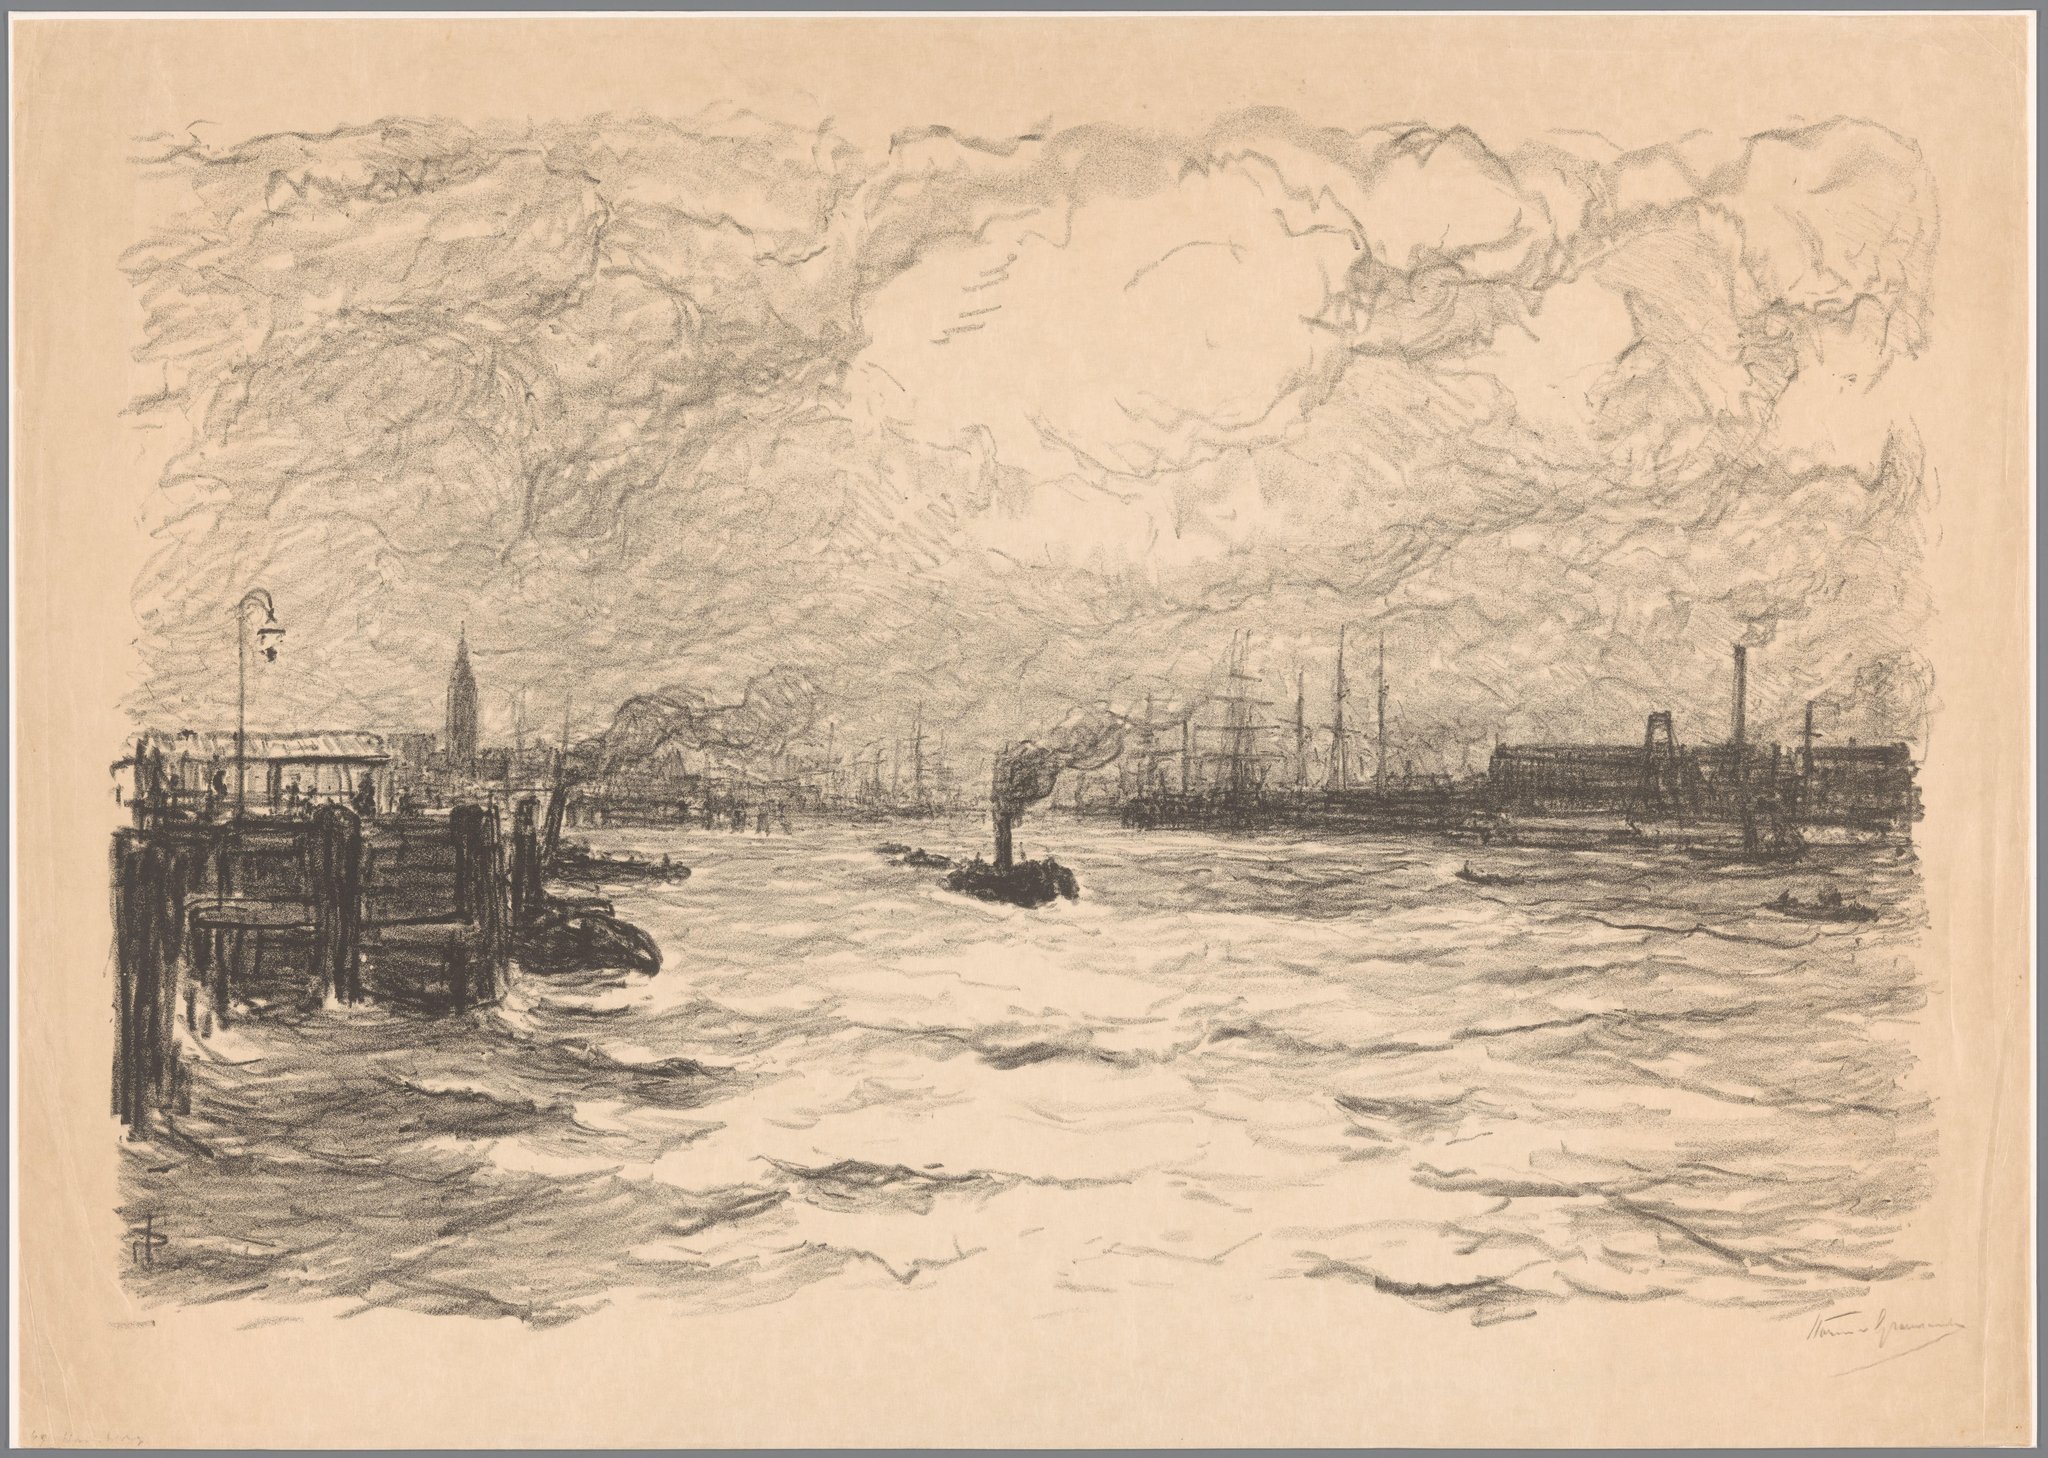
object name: print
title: Havengezicht in Hamburg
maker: carel nicolaas storm van s-gravesande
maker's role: draughtsman, print maker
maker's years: 1841-1924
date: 1851-1924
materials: paper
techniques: lithograph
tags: harbour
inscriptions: collector's mark: Lugt 2228, number: ‘49’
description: Mogelijk vermeld in: Storm van 's-Gravesande, Charles. Catalogue des eaux-fortes et lithographies. New York: s.n., 1903, of in een onbekende latere uitgave van het manuscript. Vermoedelijk vermeld als catalogusnummer 49.